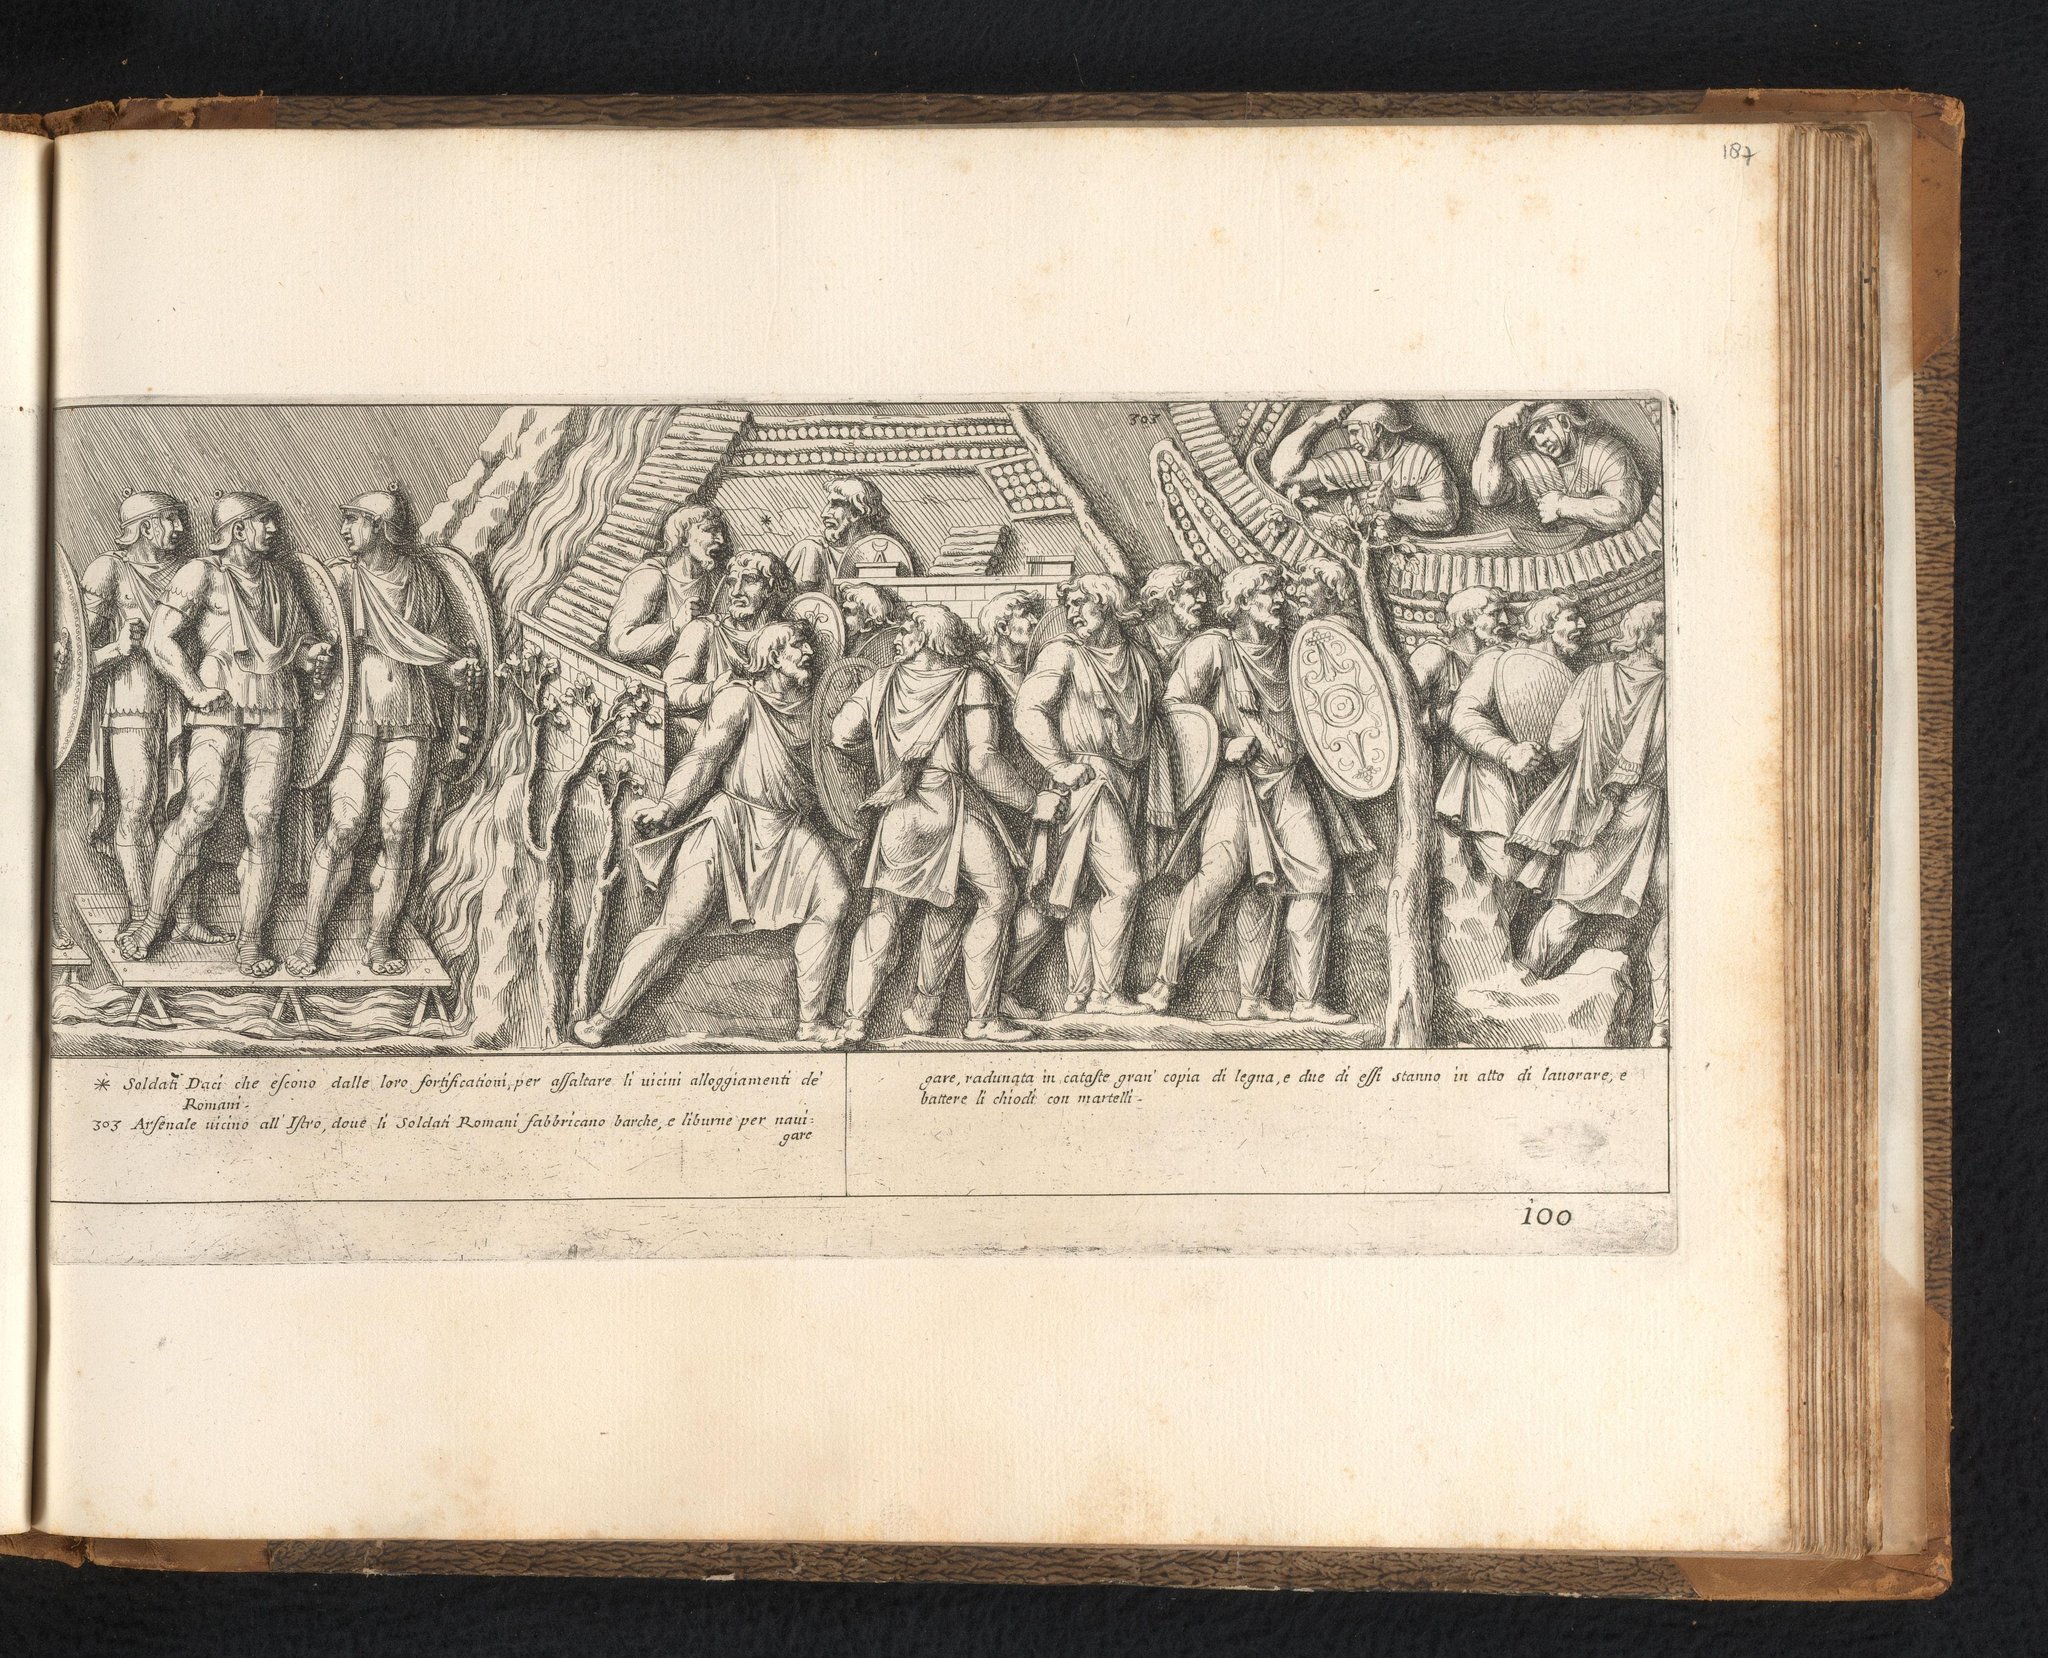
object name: album leaf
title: Zuil van Trajanus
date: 1637-1691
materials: paper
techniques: etching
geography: rome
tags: triumphal column with helical friezes, piece of sculpture, reproduction of a piece of sculpture, the soldier; the soldier's life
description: Detail van het spiraalvormige gebeeldhouwde fries op de Zuil van Trajanus. Het fries toont de oorlogen tussen de Romeinen en de Daciërs. Verklarende nummers in de ondermarge. Prent maakt deel uit van een album.